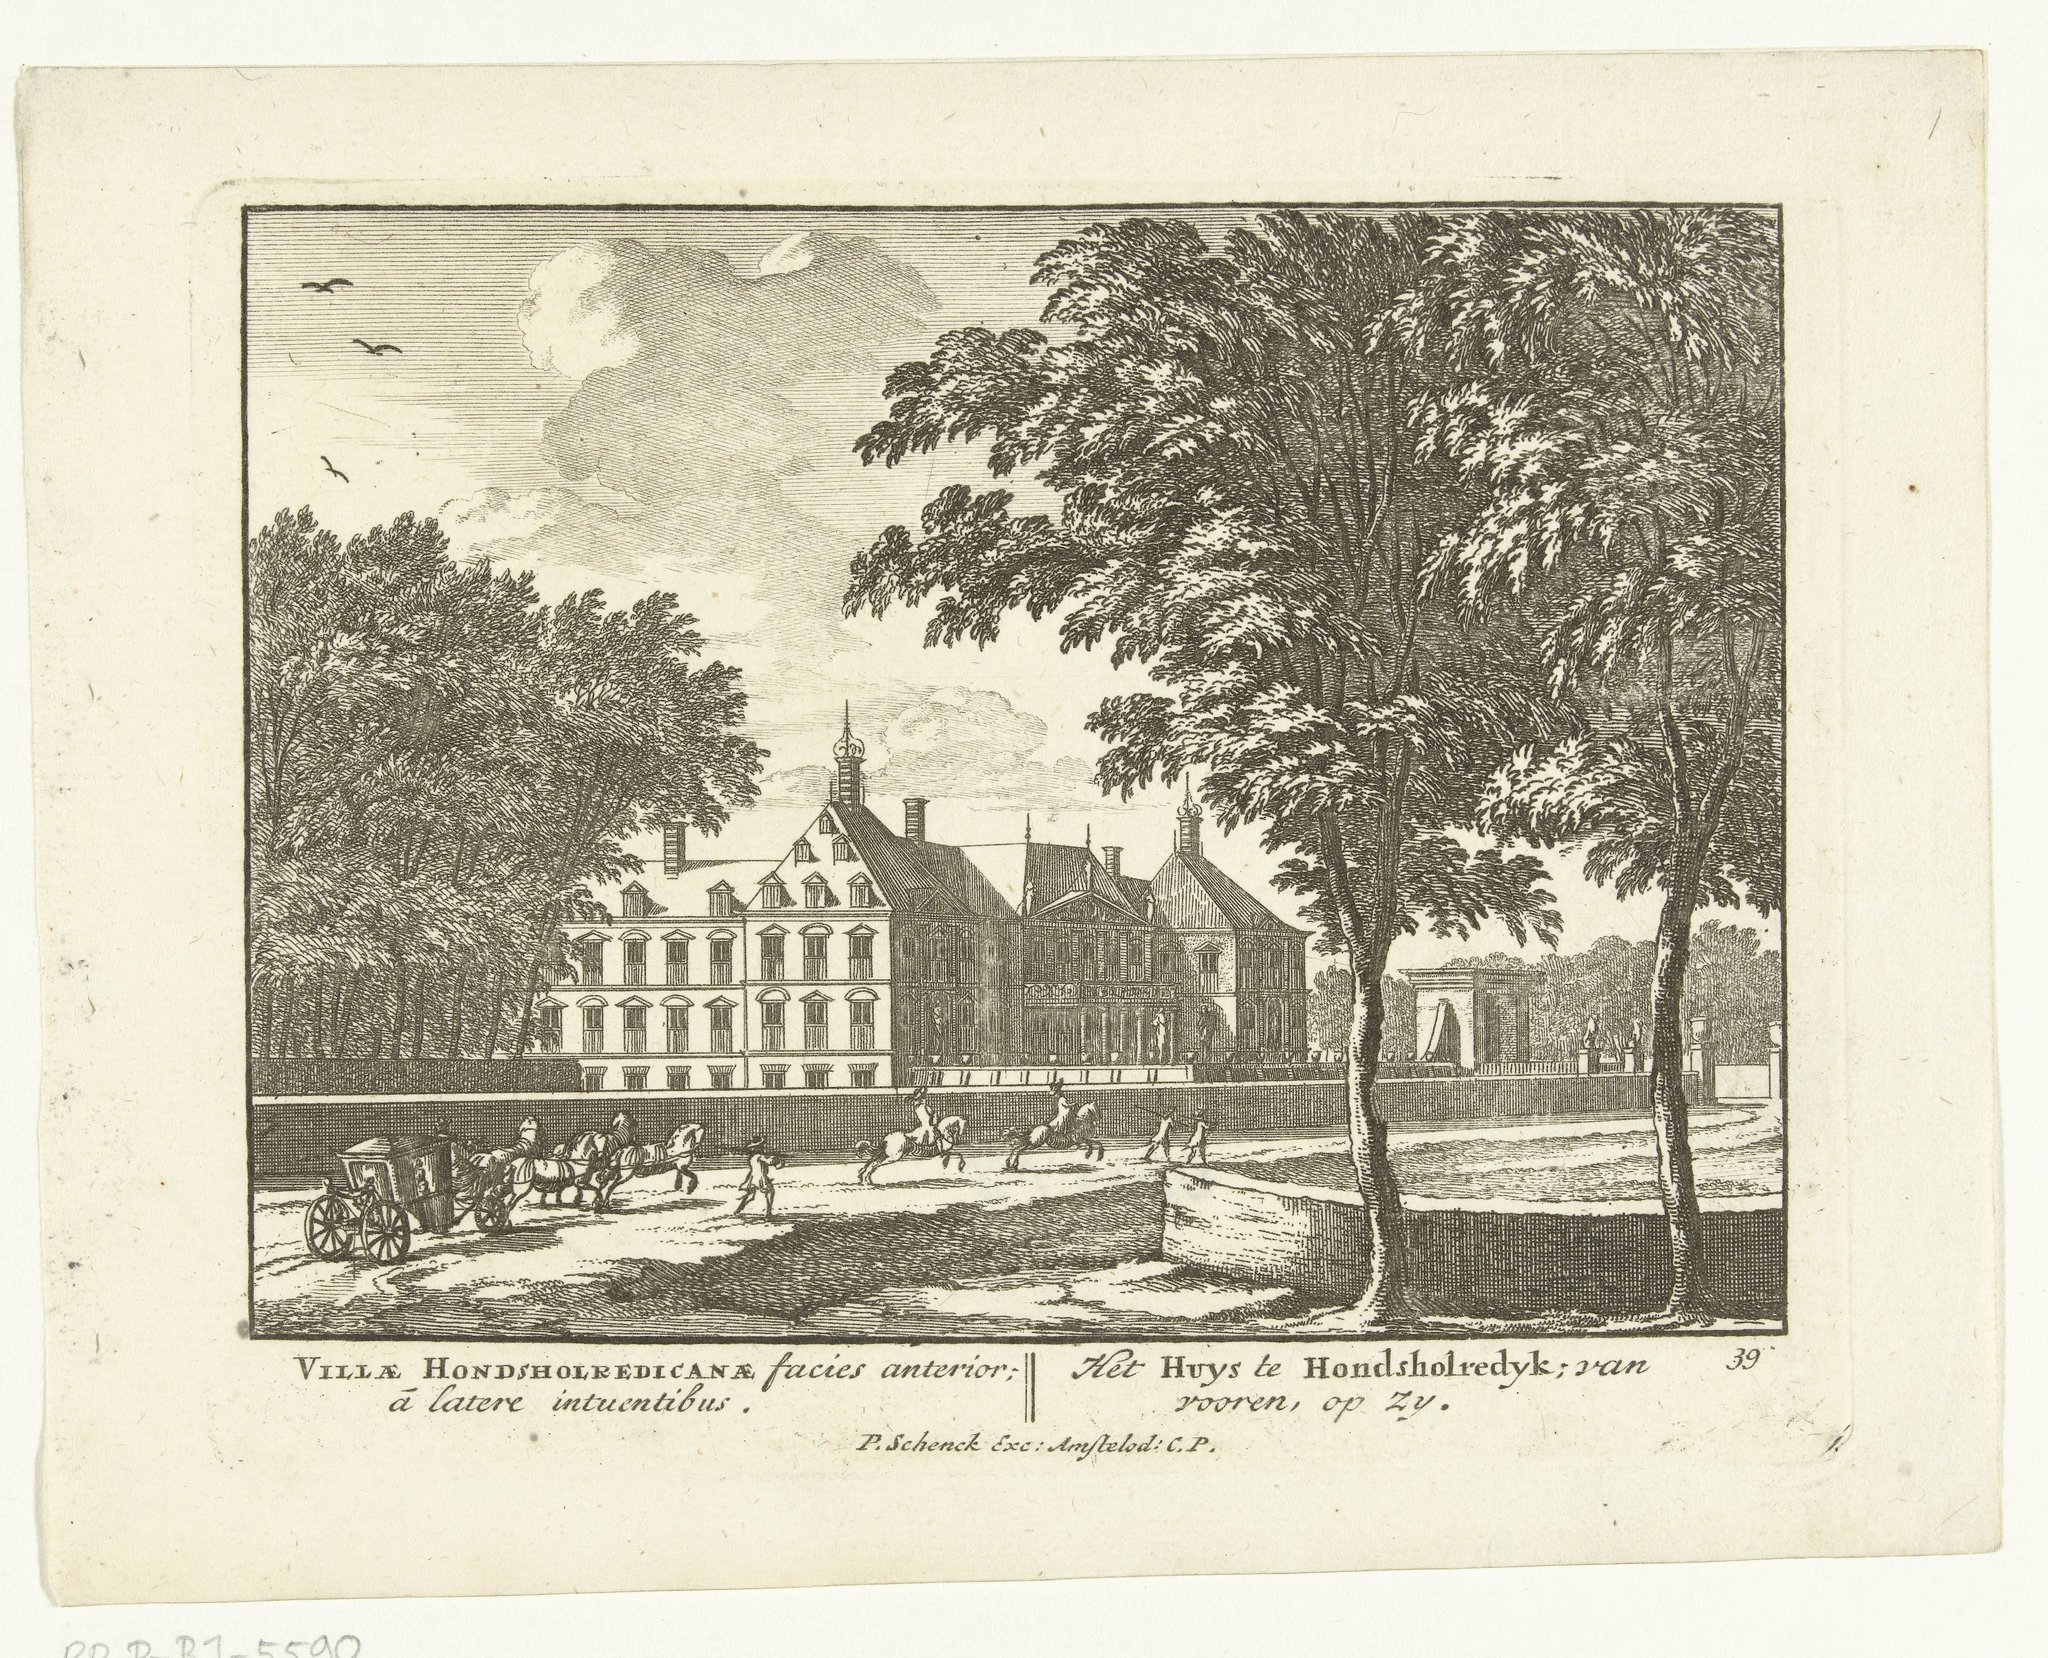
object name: print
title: Gezicht op Huis Honselaarsdijk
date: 1695-1705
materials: paper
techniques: etching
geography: amsterdam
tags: palace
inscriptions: collector's mark: Lugt 2228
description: Een koets voorafgegaan door ruiters en mannen te voet rijdt over de oprijlaan naar Huis Honselaarsdijk. Prent uit een serie van 71 prenten met Rijnlandschappen, gezichten op vorstelijke paleizen en stadsgezichten uit Den Haag en Amsterdam.